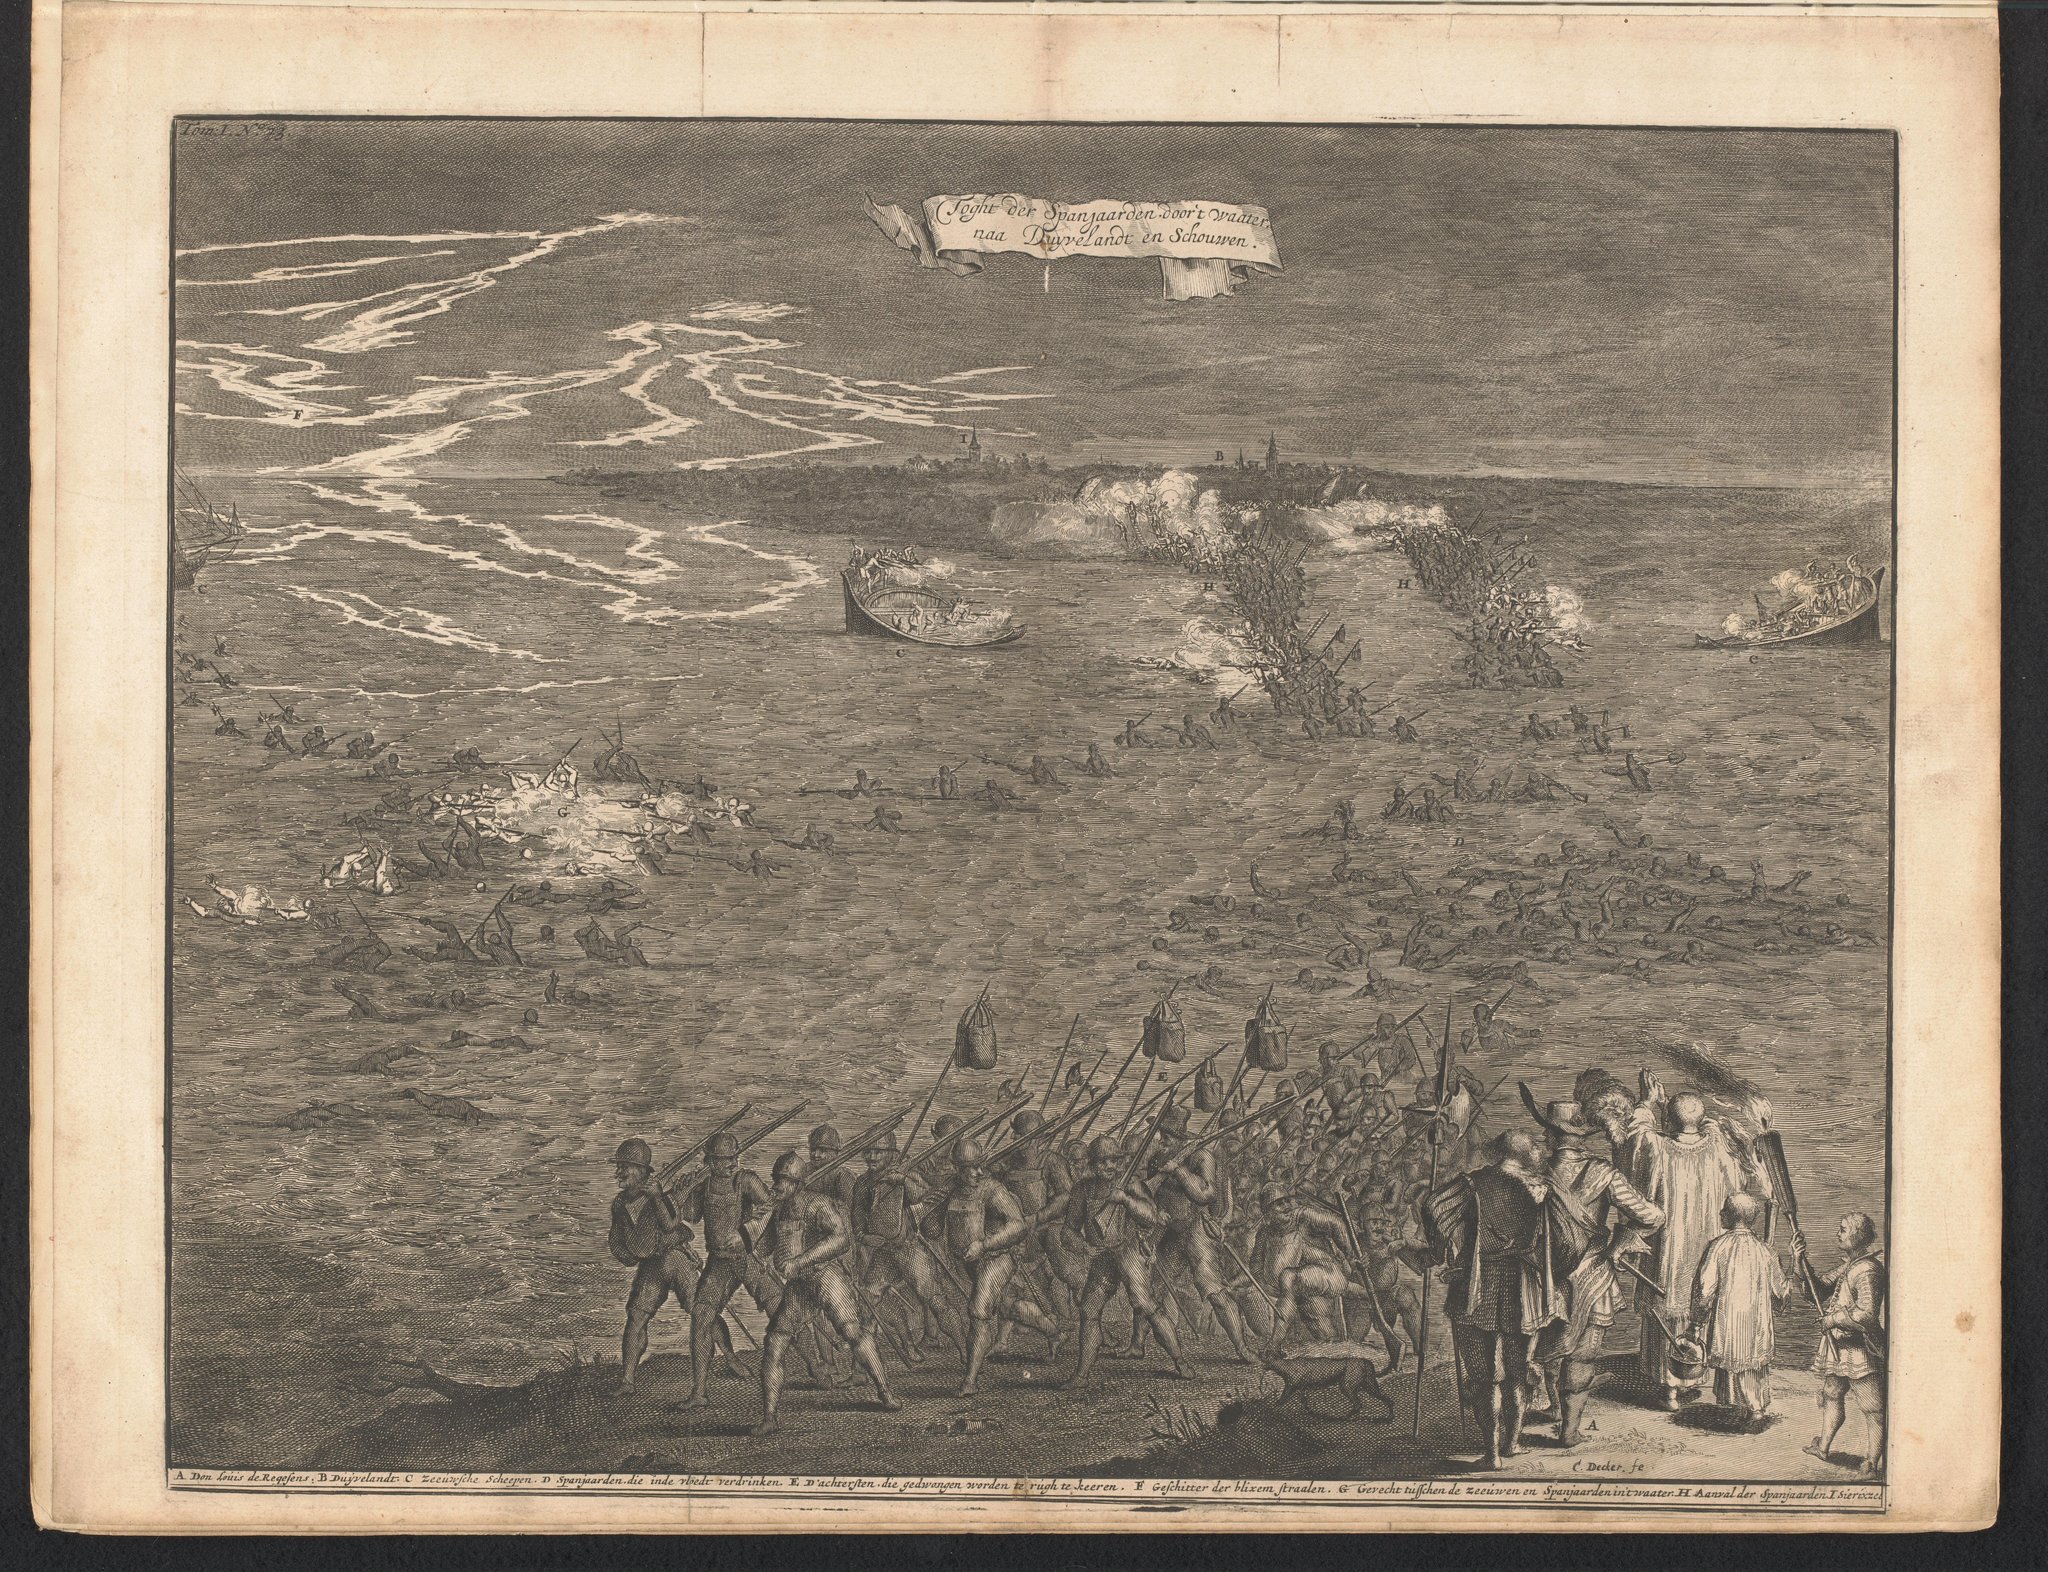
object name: print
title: Toght der Spanjaarden door 't waater naa Duyveland en Schouwen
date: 1730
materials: paper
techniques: etching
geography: northern netherlands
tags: brussels, mayor, luis de zúñiga y requesens, army 'en route'